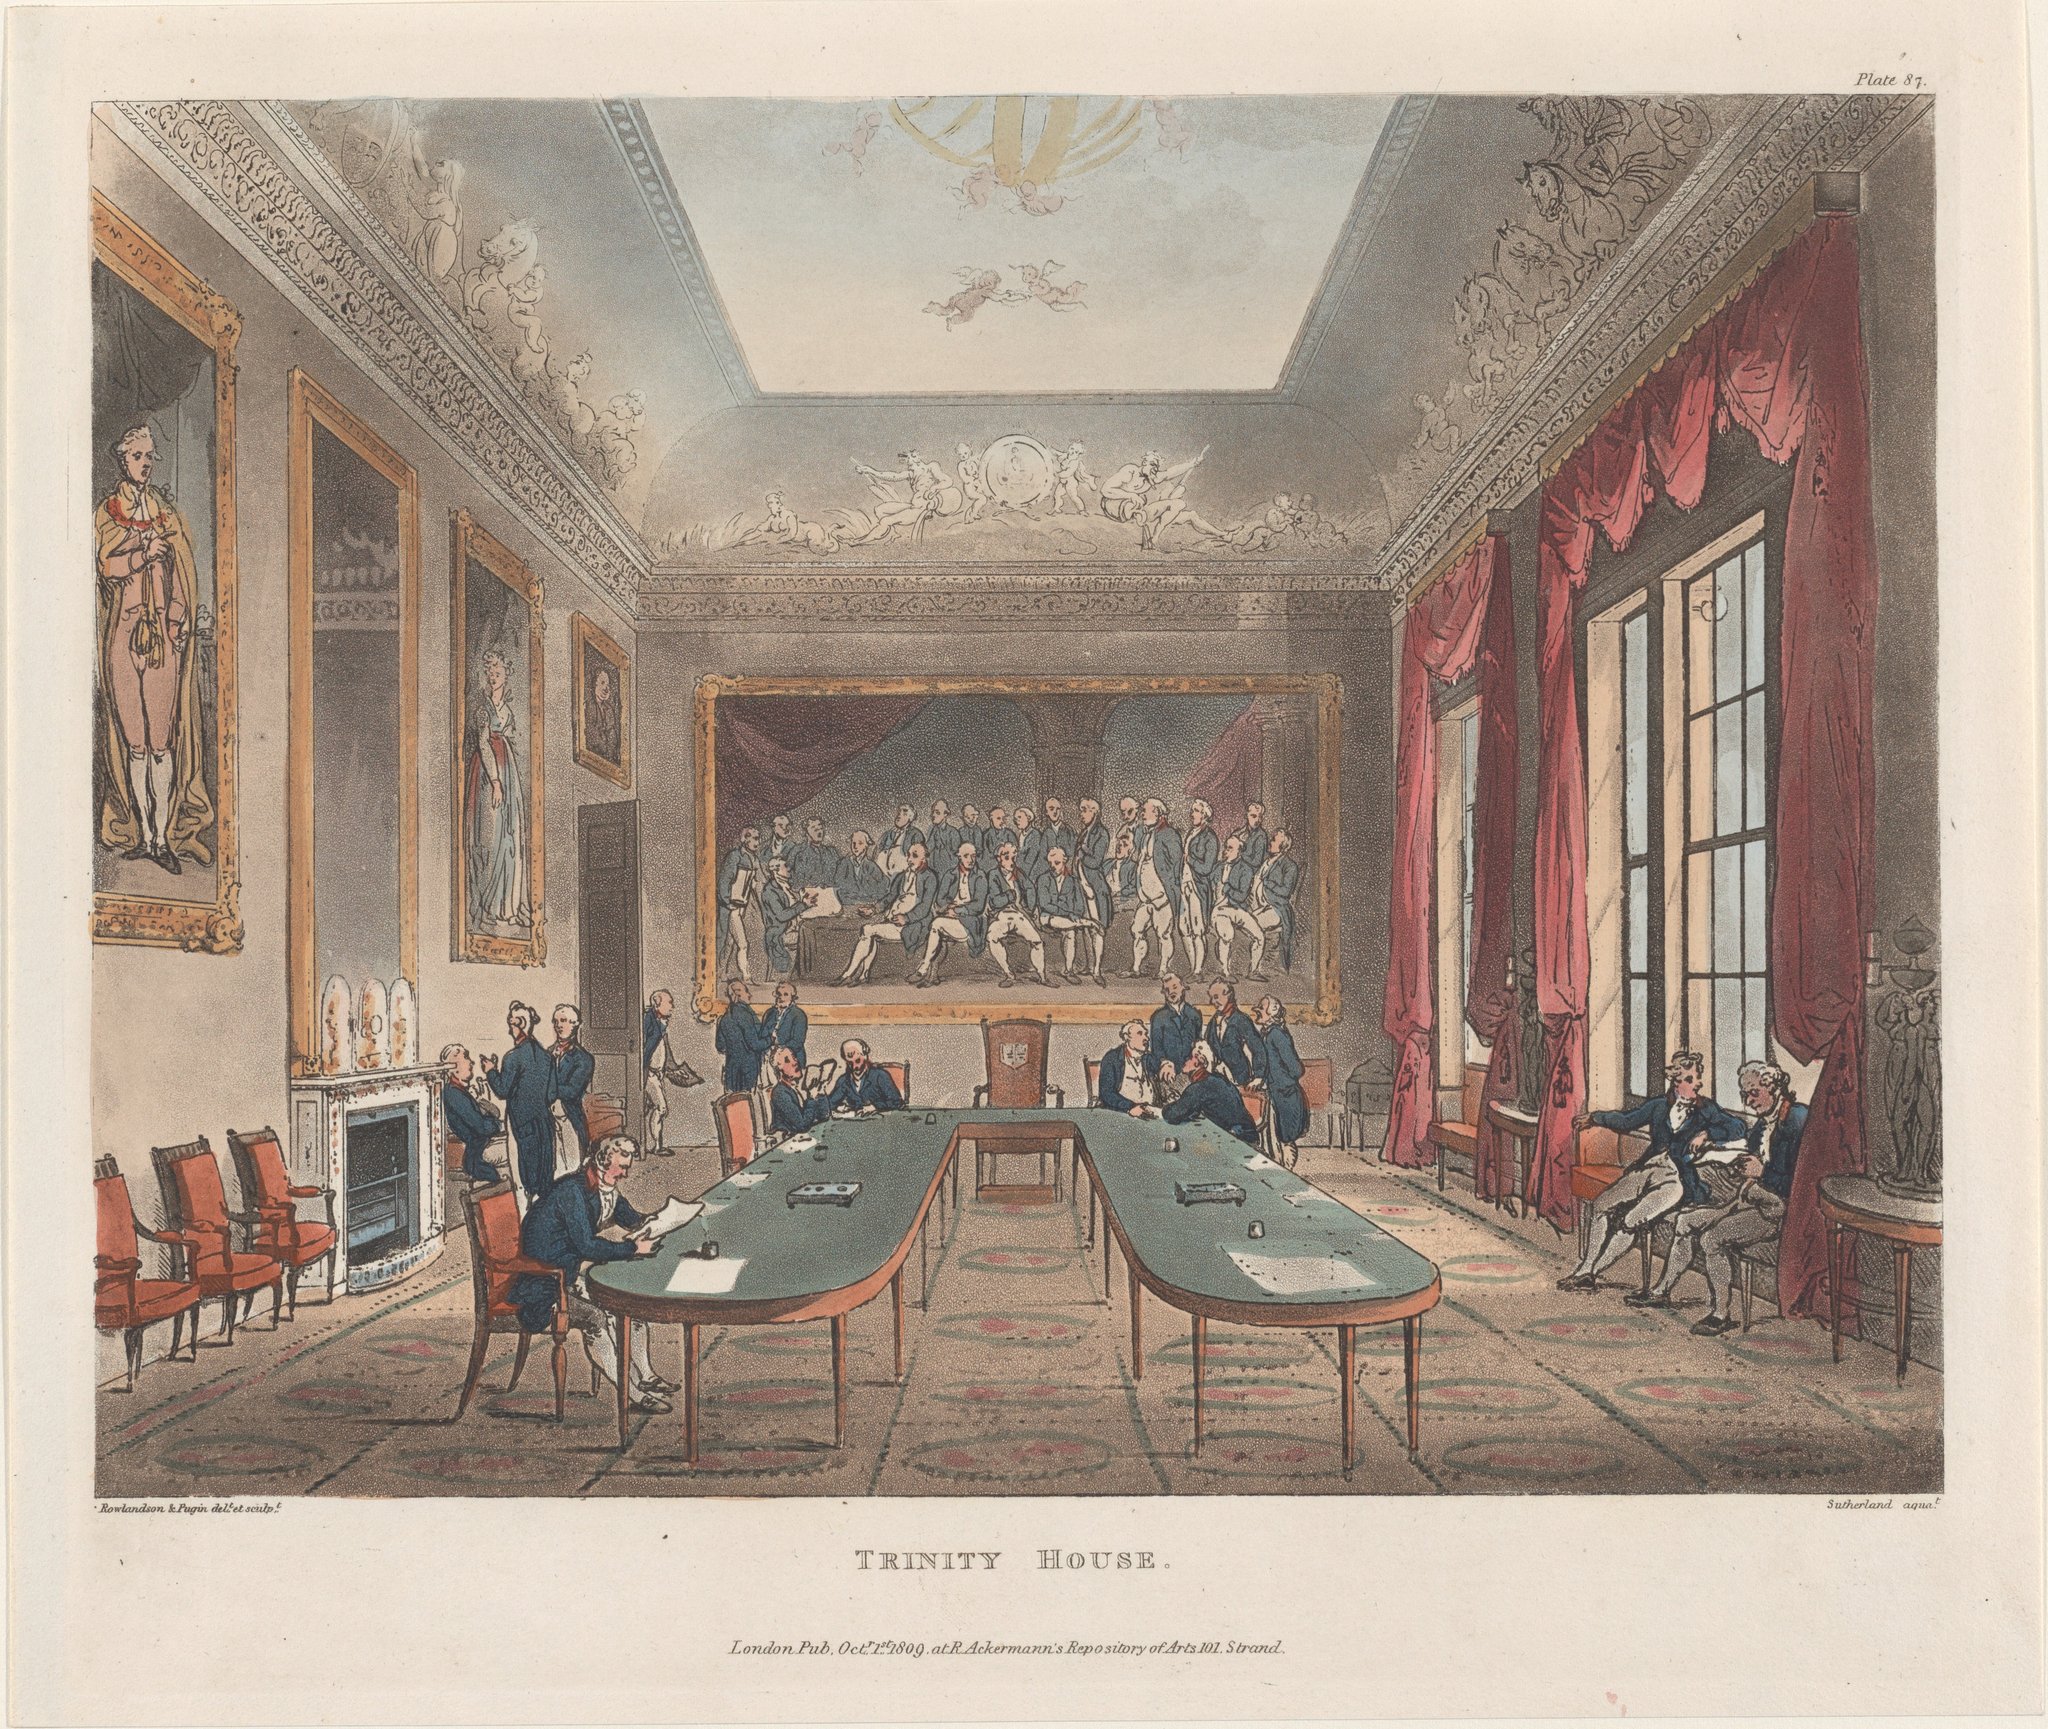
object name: print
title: Trinity House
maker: thomas rowlandson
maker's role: artist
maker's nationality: british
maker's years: 1757-1827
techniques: aquatint, etching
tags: interiors,men